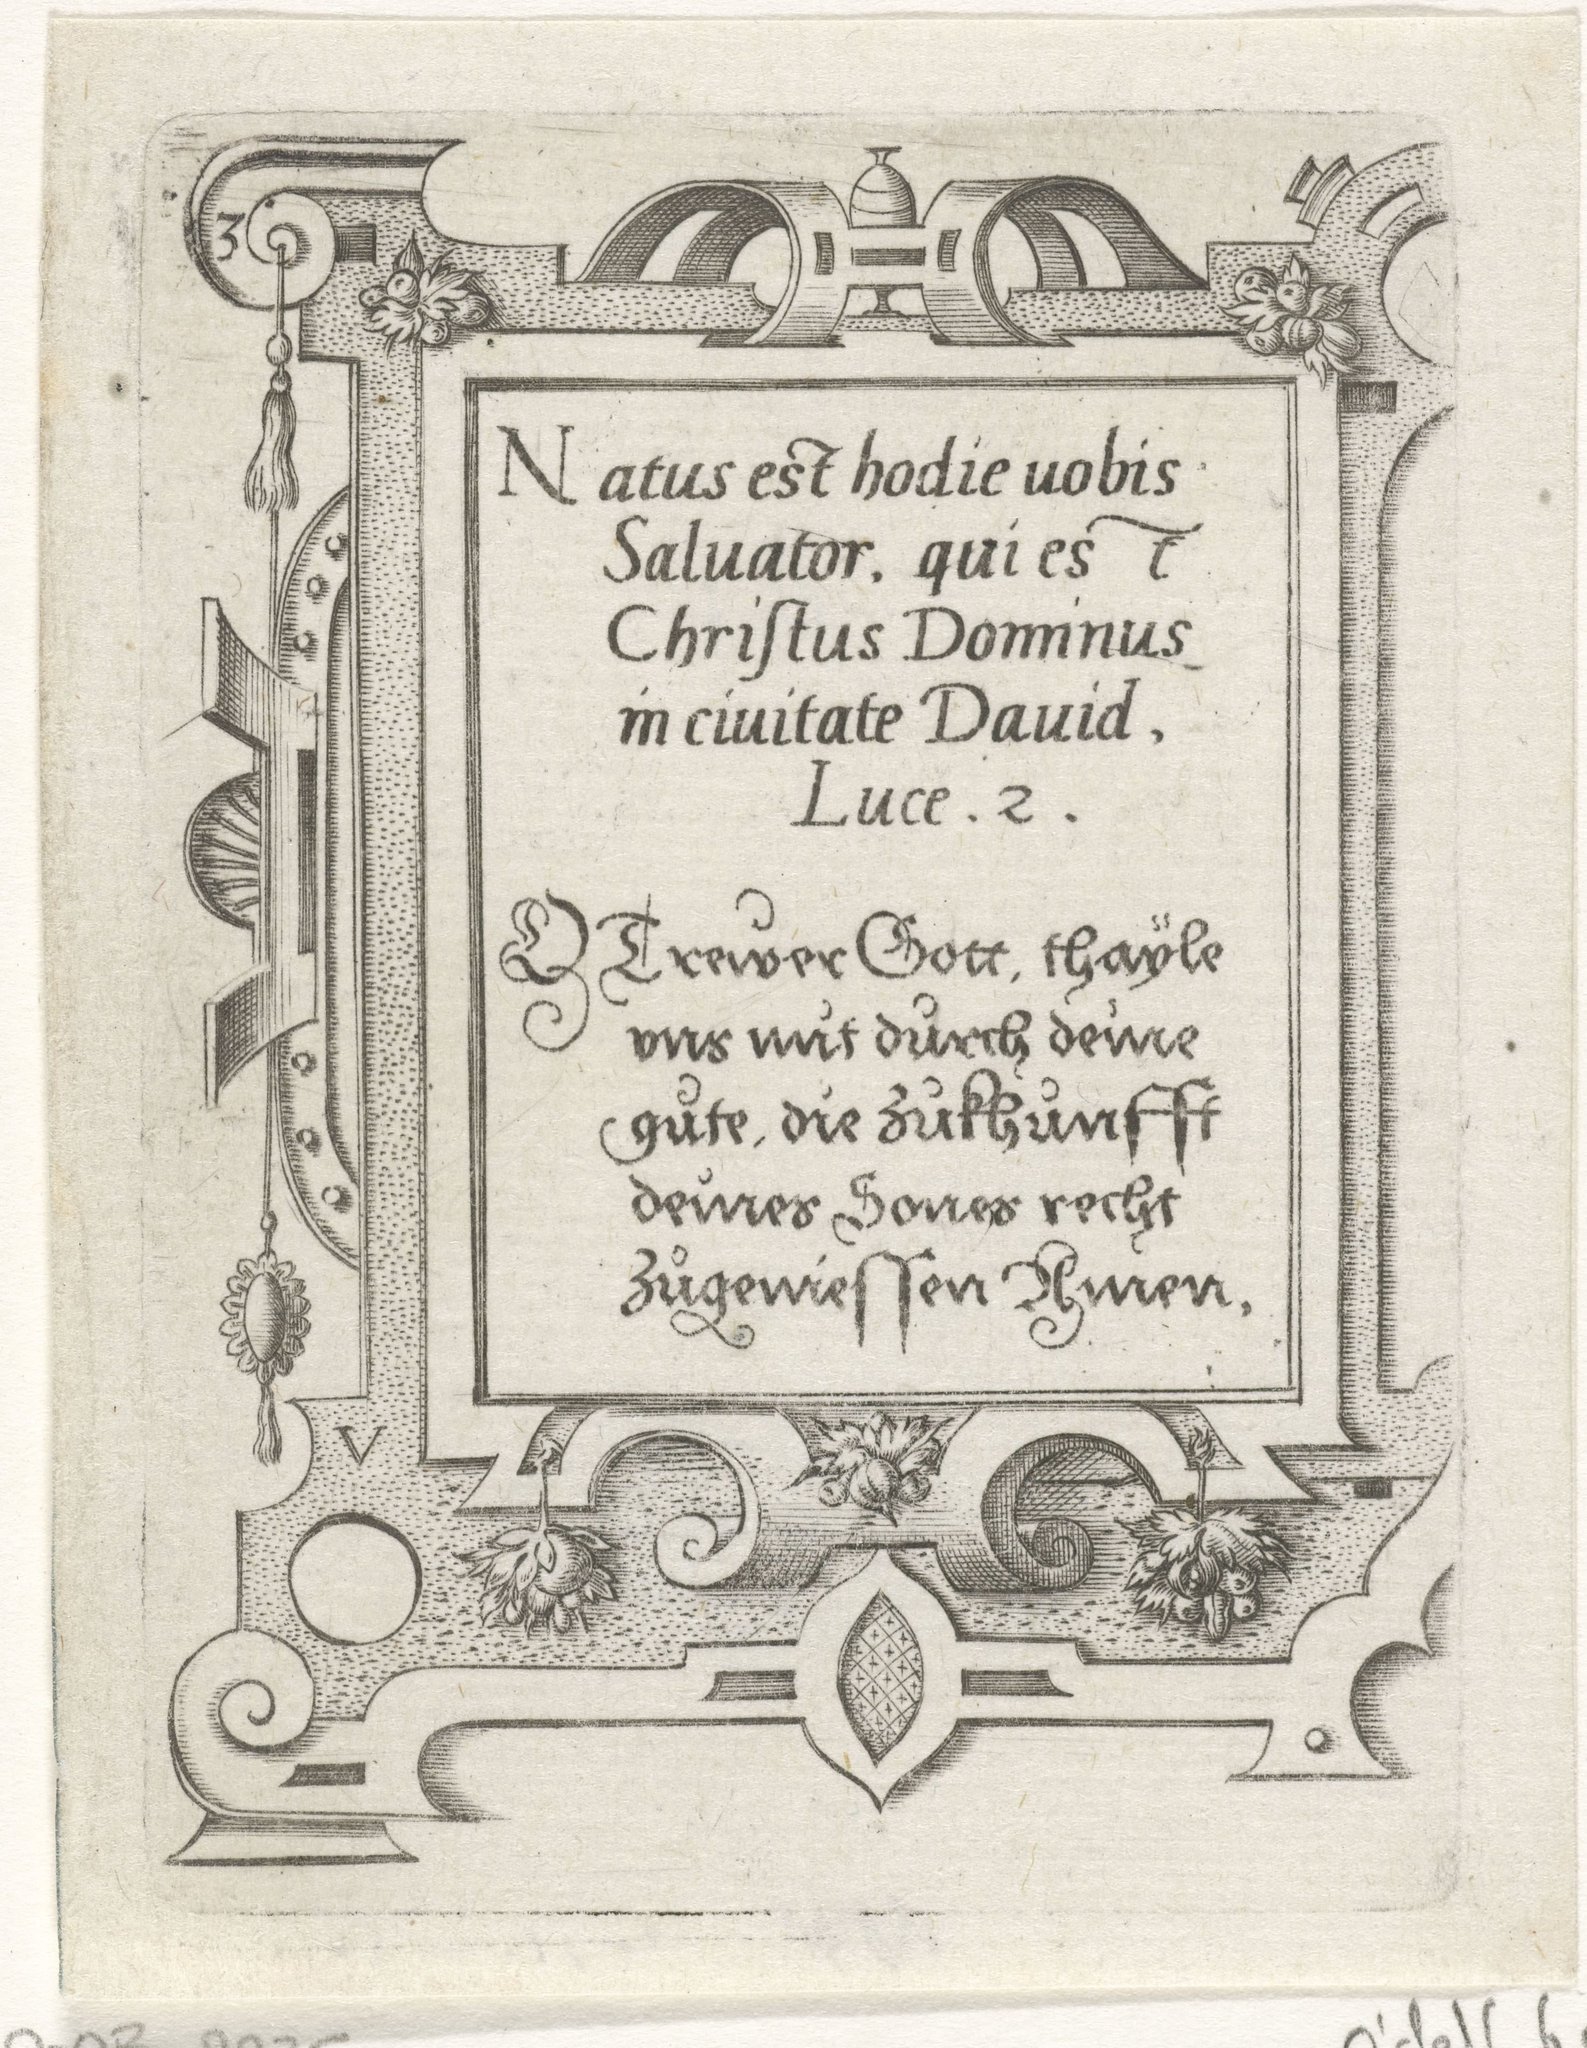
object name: print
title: Tekst: Natus est...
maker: virgilius solis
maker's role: draughtsman, print maker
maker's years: 1514-1562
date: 1524-1562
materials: paper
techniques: engraving